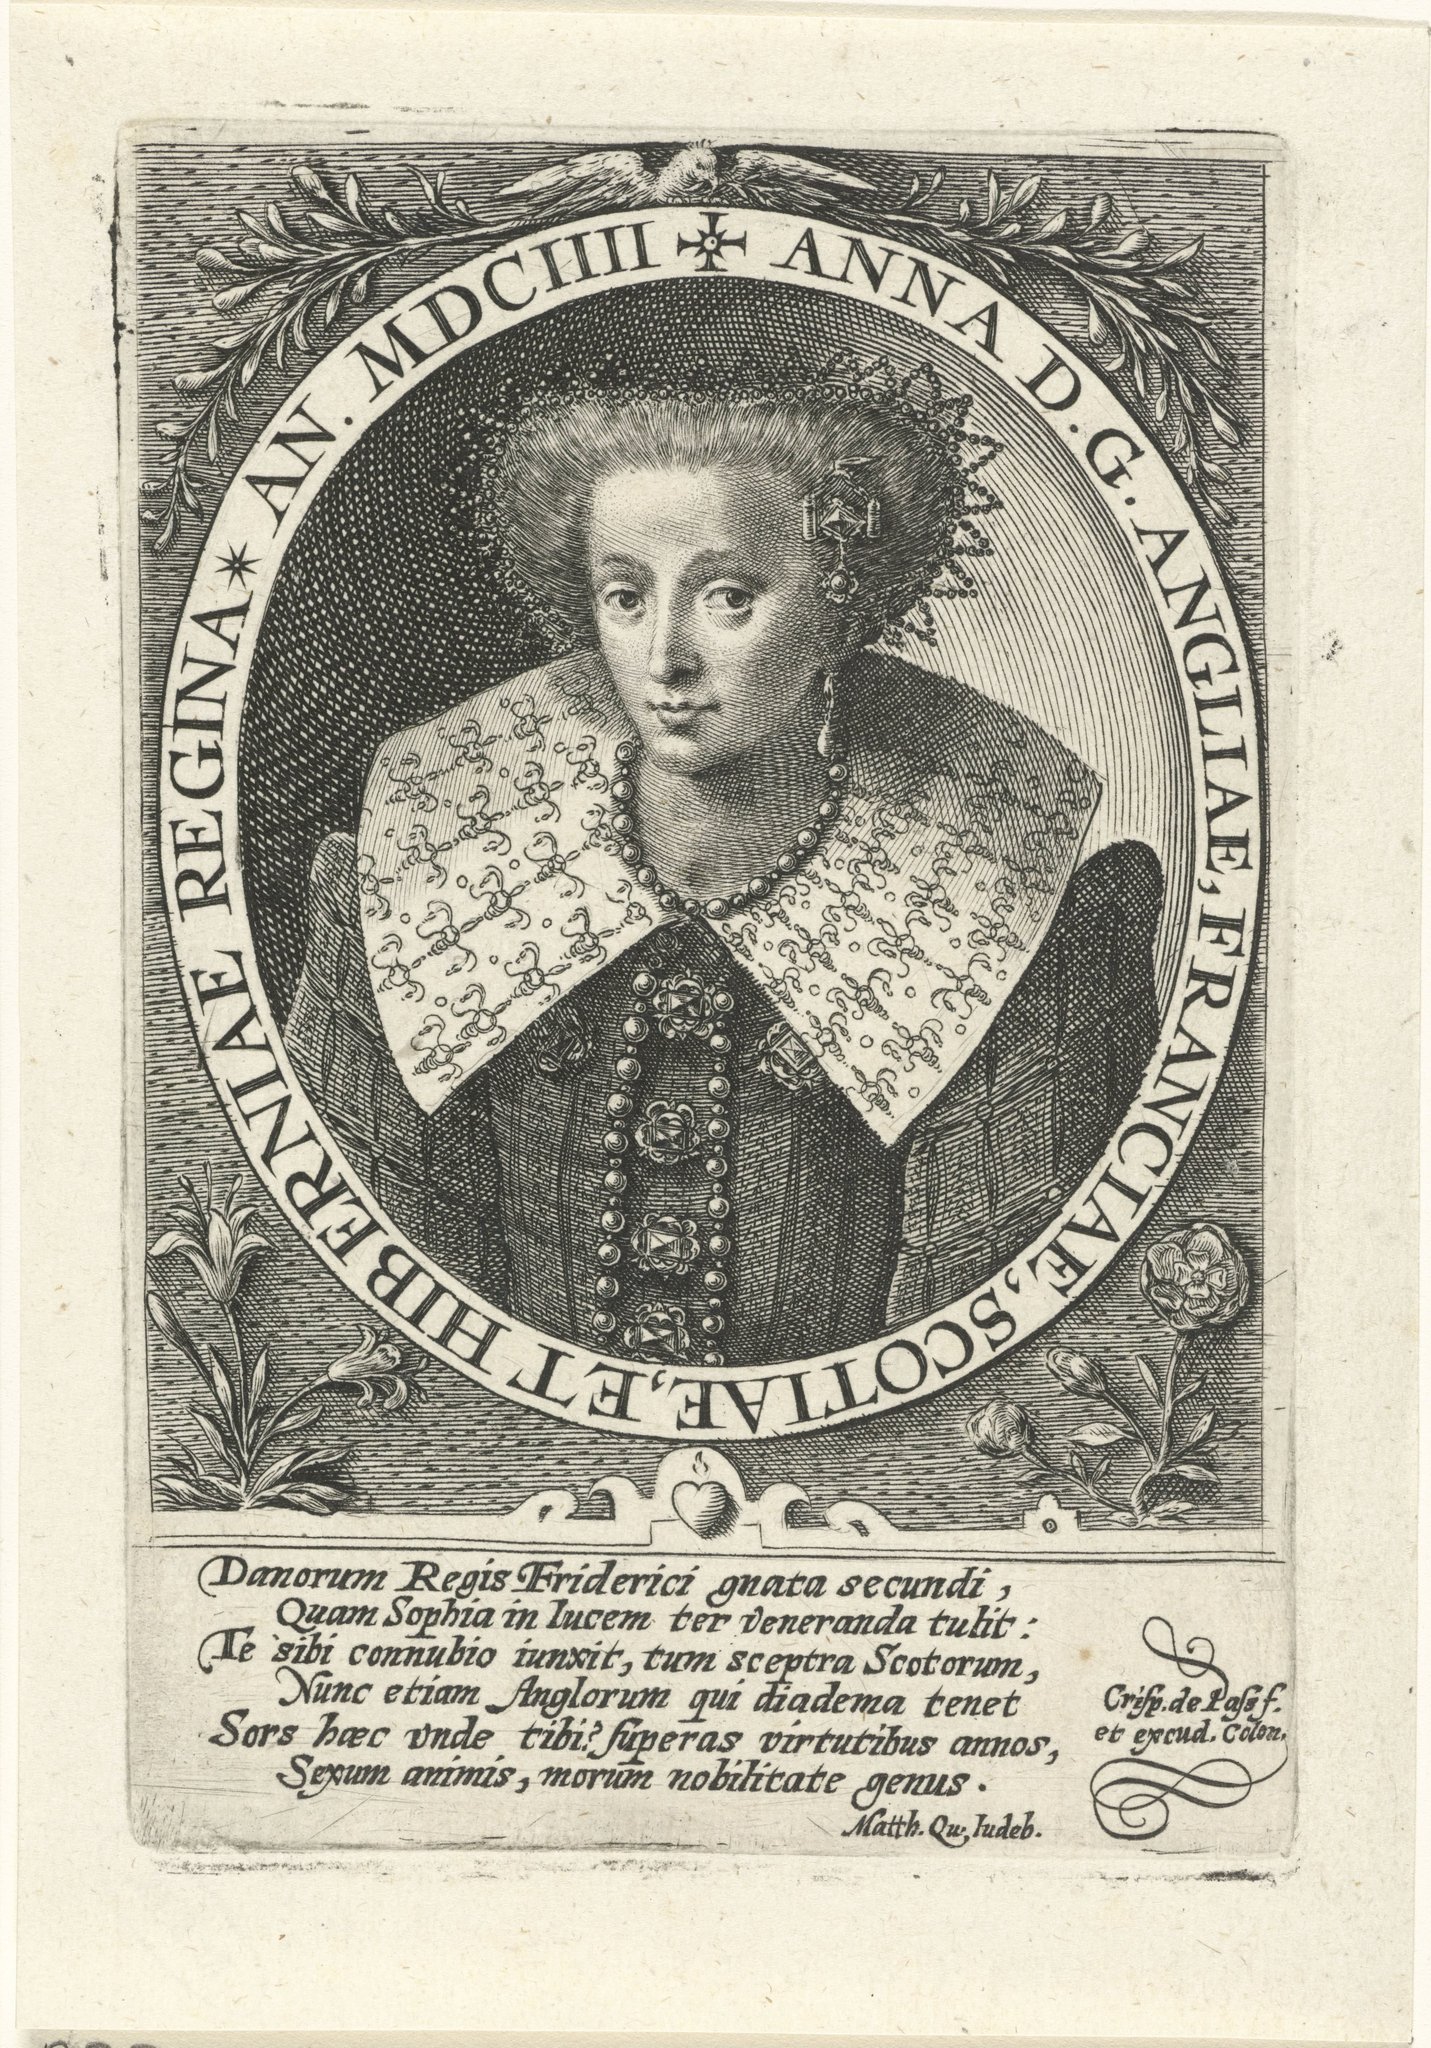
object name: print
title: Portret van Anna van Denemarken, koningin van Engeland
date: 1604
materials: paper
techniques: engraving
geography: cologne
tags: koningin, anna van denemarken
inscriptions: collector's mark: Lugt 2228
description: Portret van Anna van Denemarken, gemalin van koning Jacobus I van Engeland. In het randschrift van de omlijsting de naam en functie van de geportretteerde in het Latijn. In de marge een zesregelig lofdicht in het Latijn.